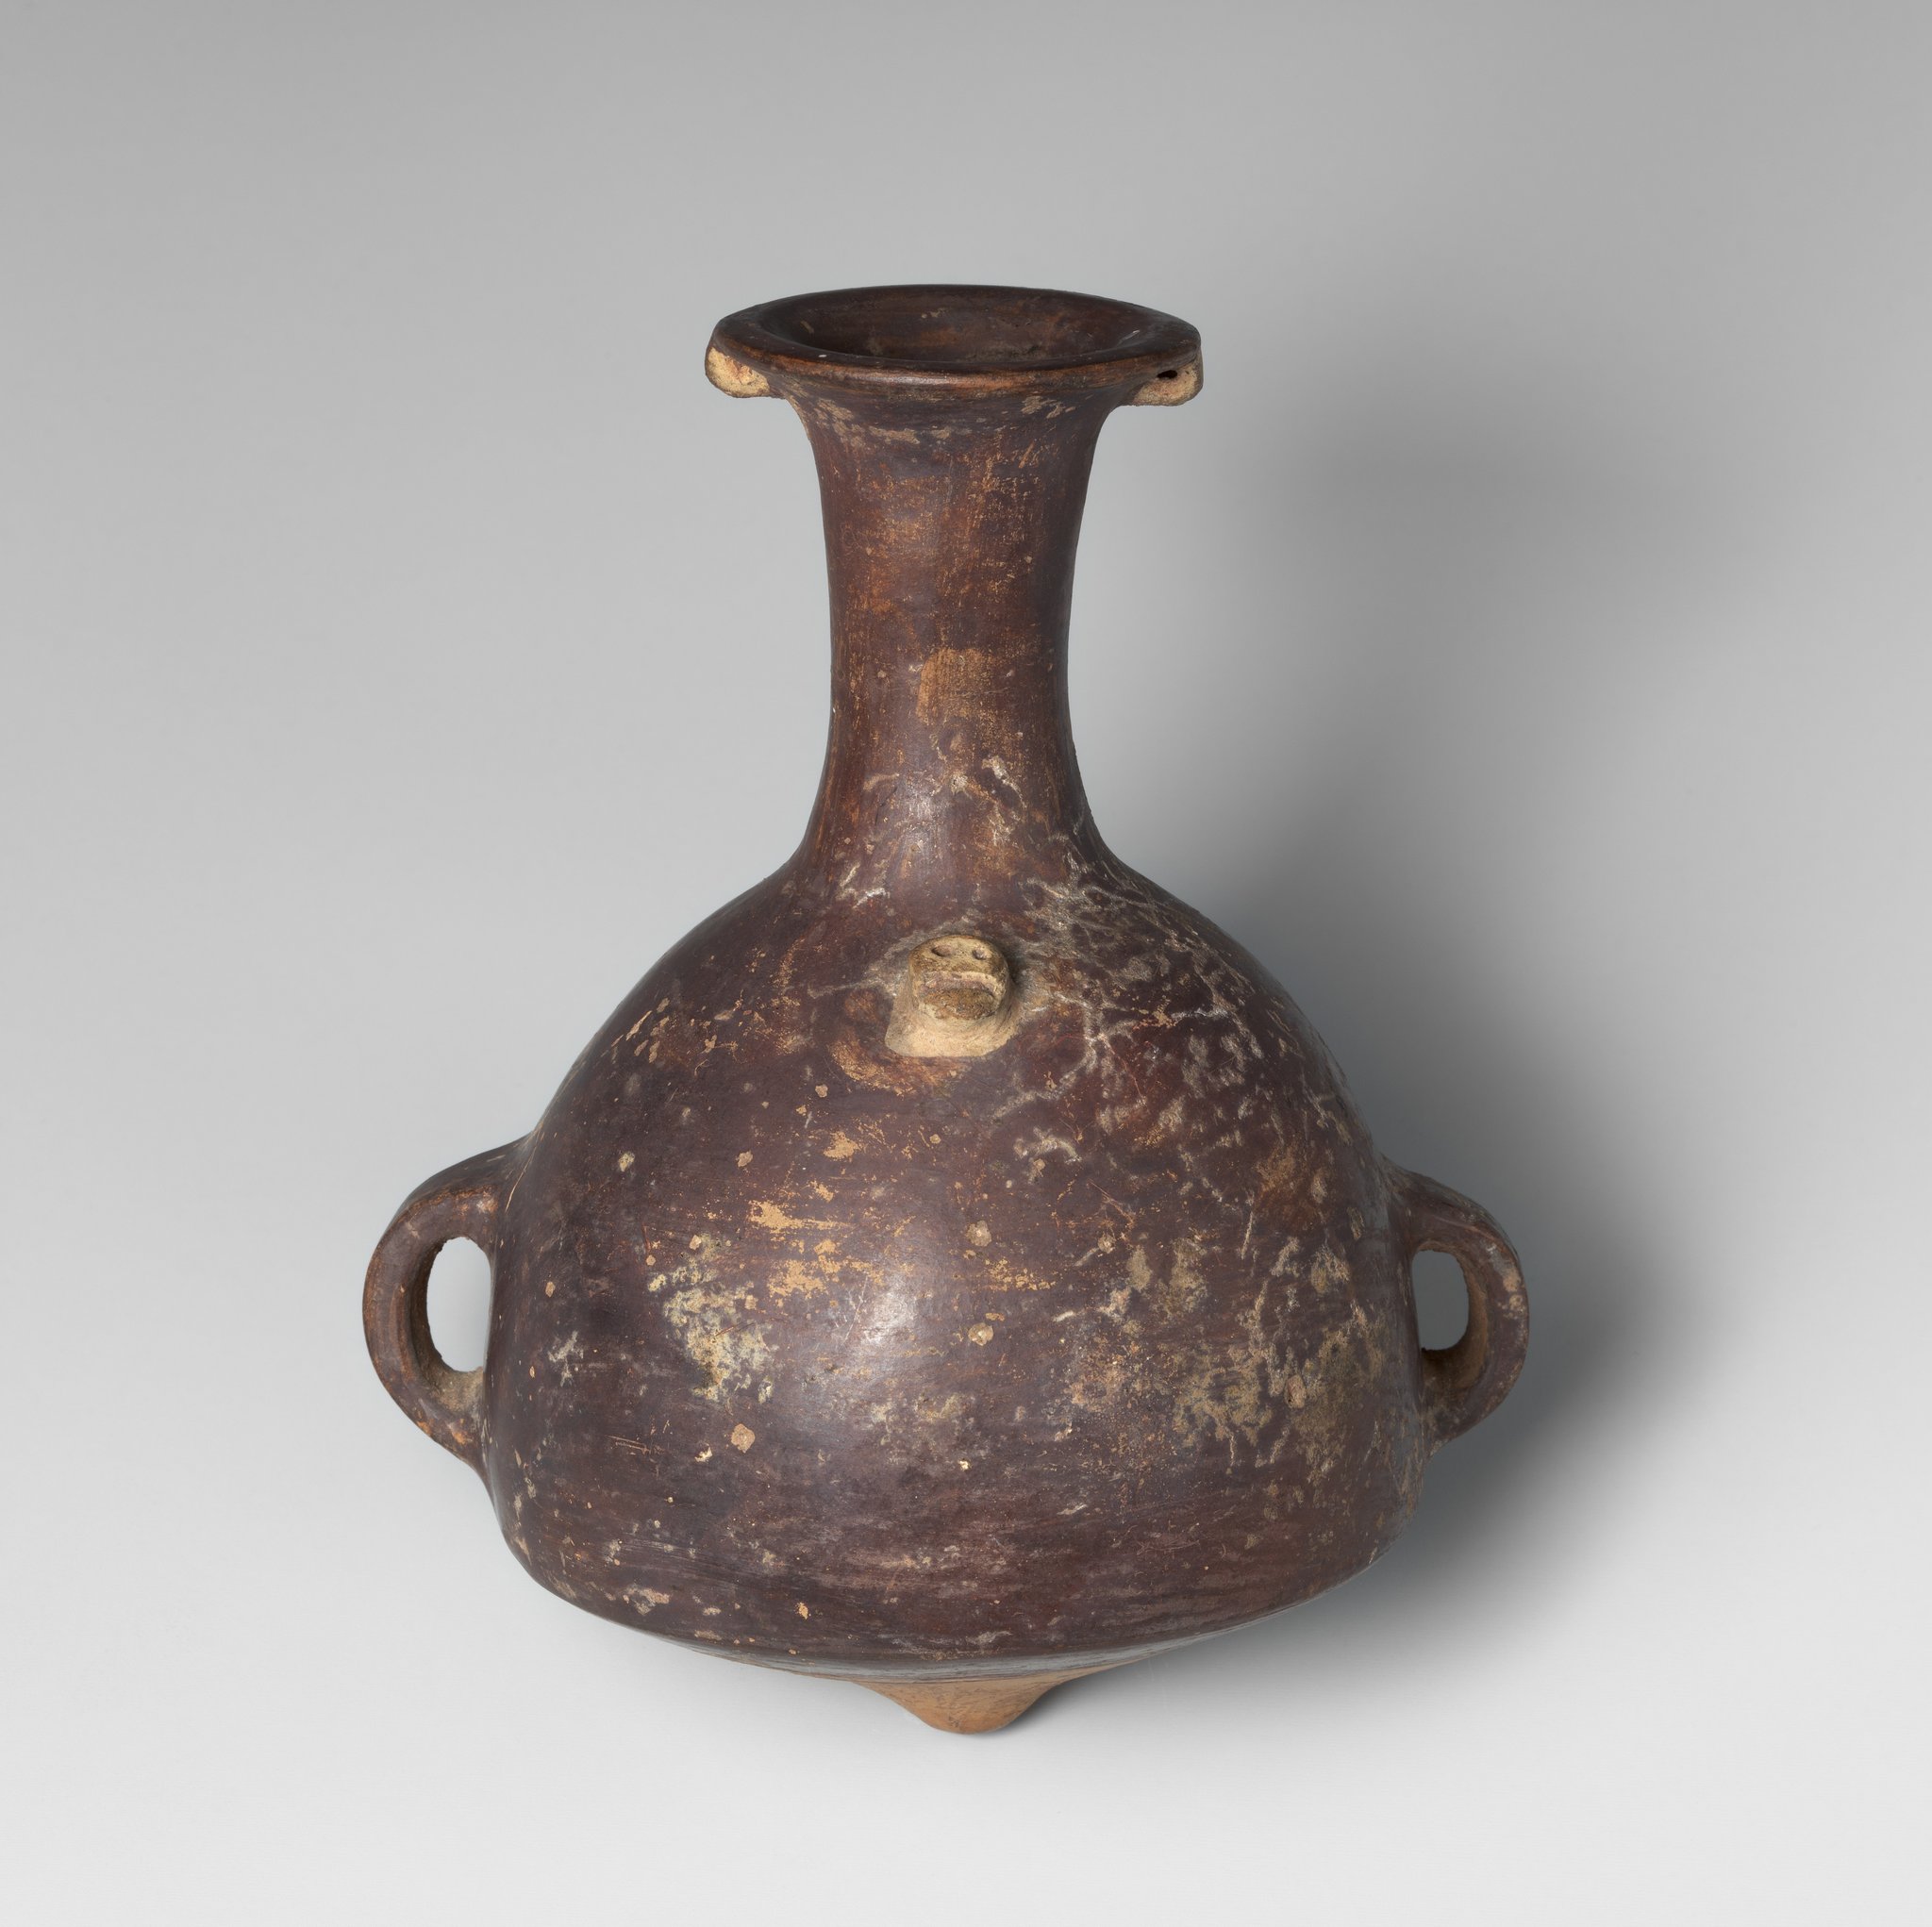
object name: bottle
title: Storage Jar (Aryballus)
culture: inca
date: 1401-1533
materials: ceramic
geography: peru